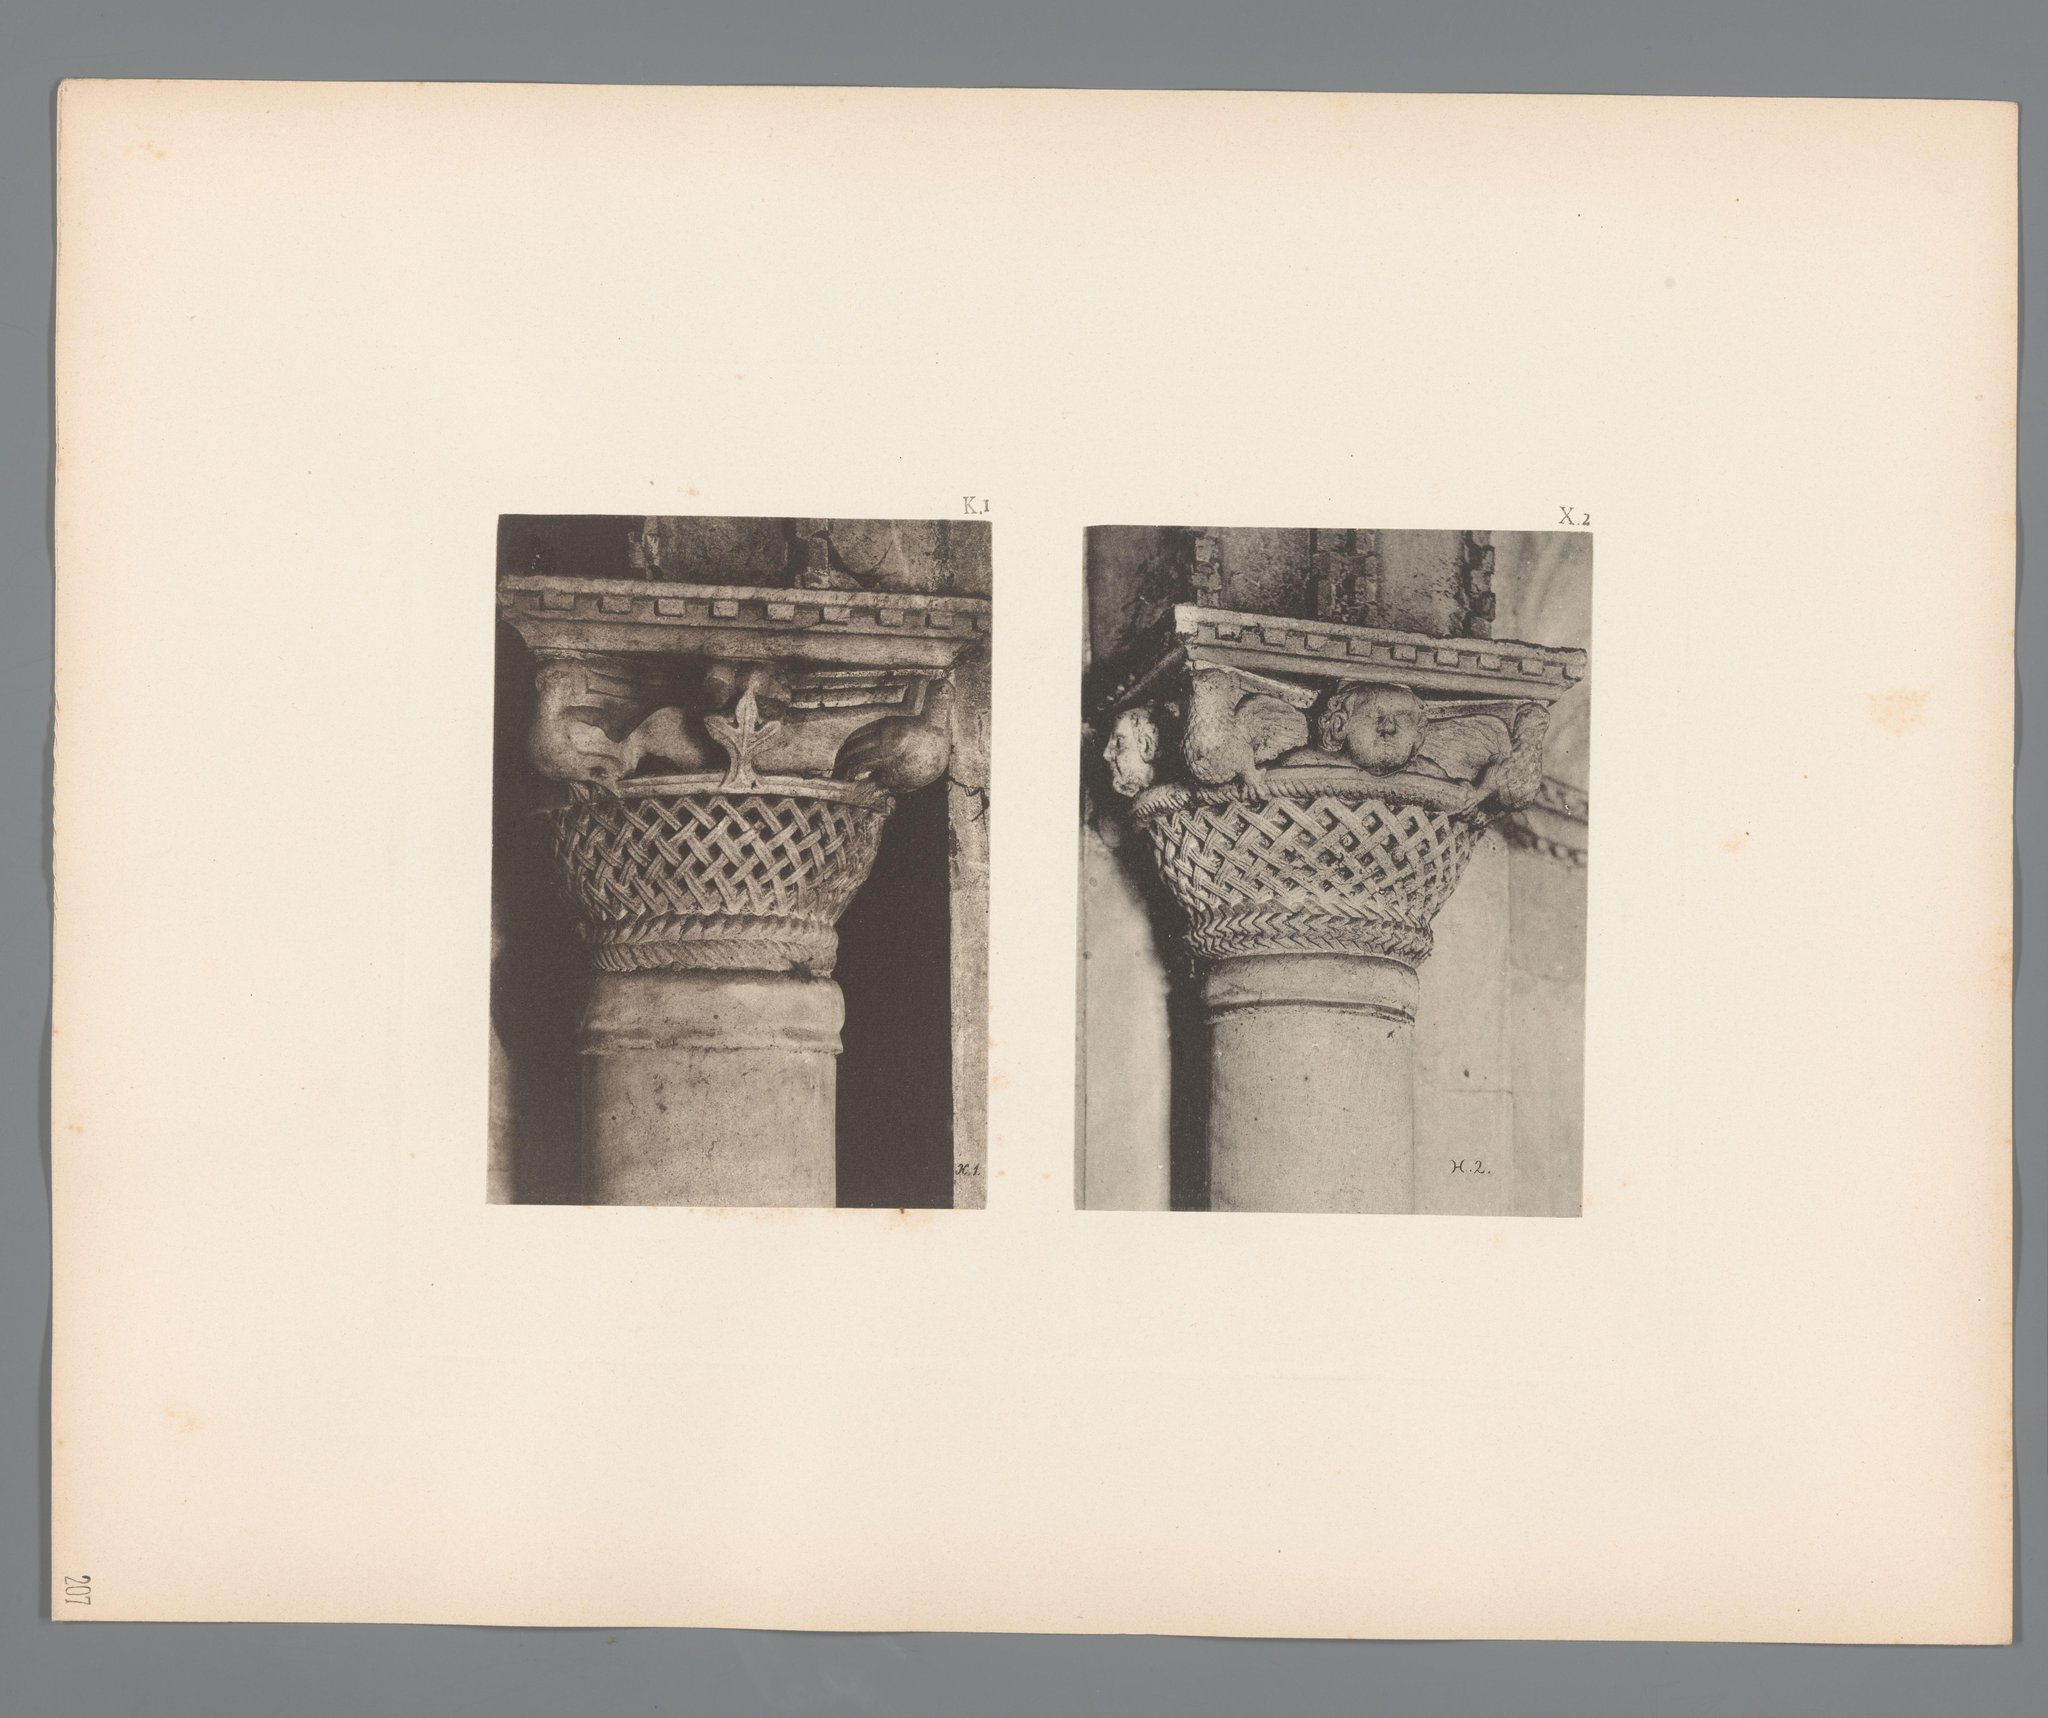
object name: photomechanical print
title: Twee afbeeldingen van kapitelen van de San Marco in Venetië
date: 1880-1885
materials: paper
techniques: photograph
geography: venice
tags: capital (~ column, pillar) (+ styles in art ~ ancient historical period), church (exterior)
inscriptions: number: ‘207’, number: ‘X.2.’, number: ‘X.2’, number: ‘K.1.’, number: ‘K.I’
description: Deze prenten maken deel uit van een omslag met 79 prenten op 53 bladen en 2 tekstbladen.